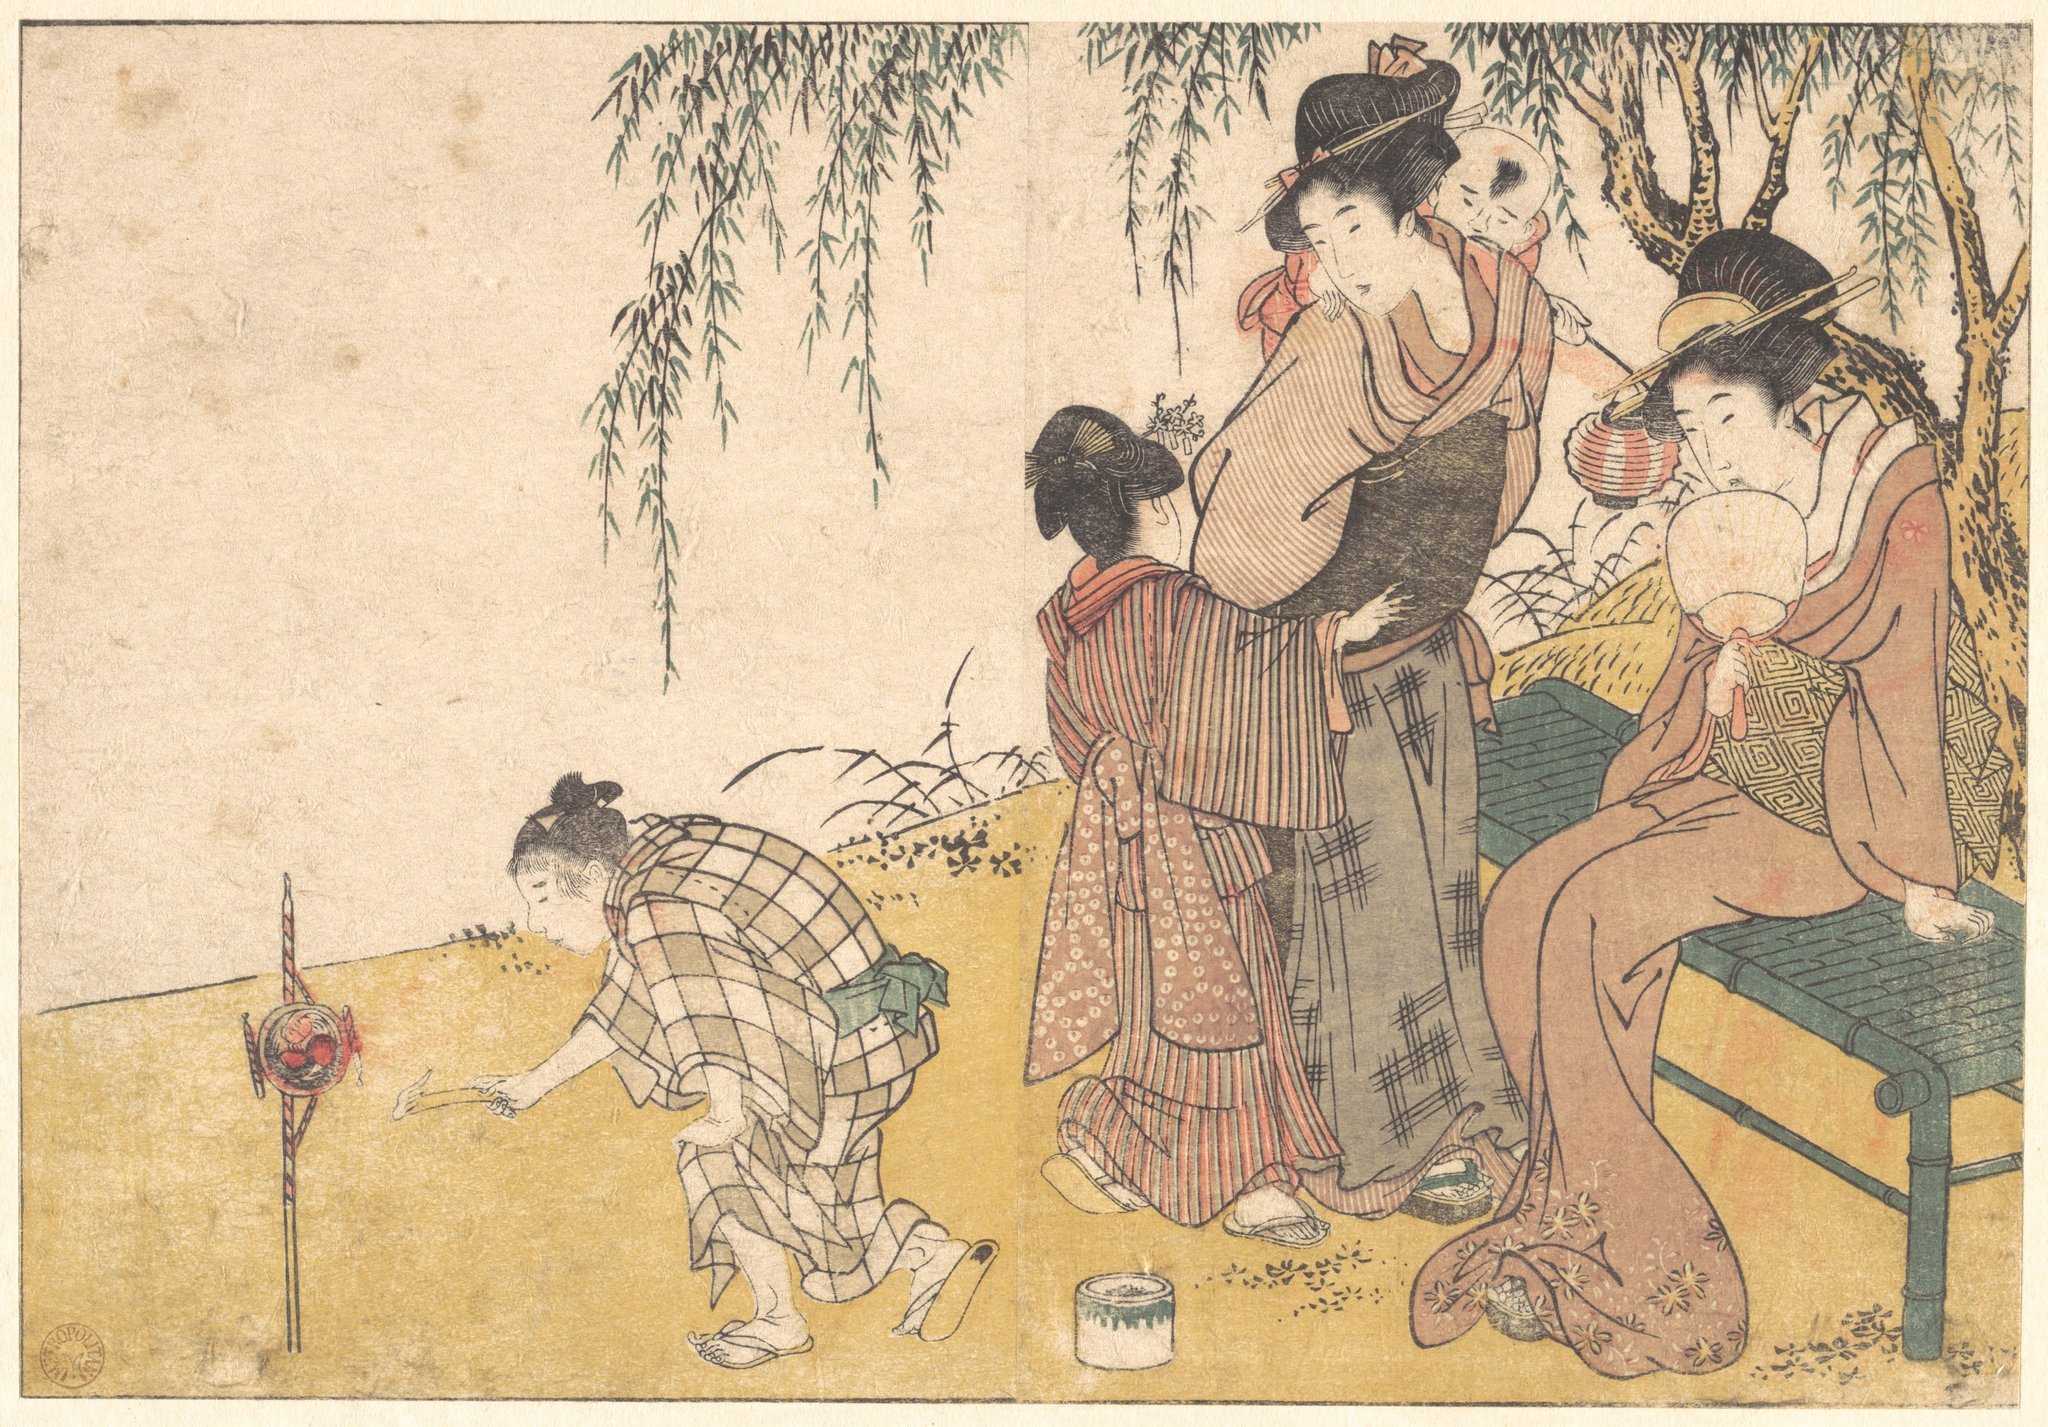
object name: woodblock print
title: A Child Lighting Fireworks, from the illustrated book Flowers of the Four Seasons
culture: japanese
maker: kitagawa utamaro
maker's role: artist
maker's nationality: japanese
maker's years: 1754-1806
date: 1801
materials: ink, paper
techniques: woodblock print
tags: children,women,fireworks